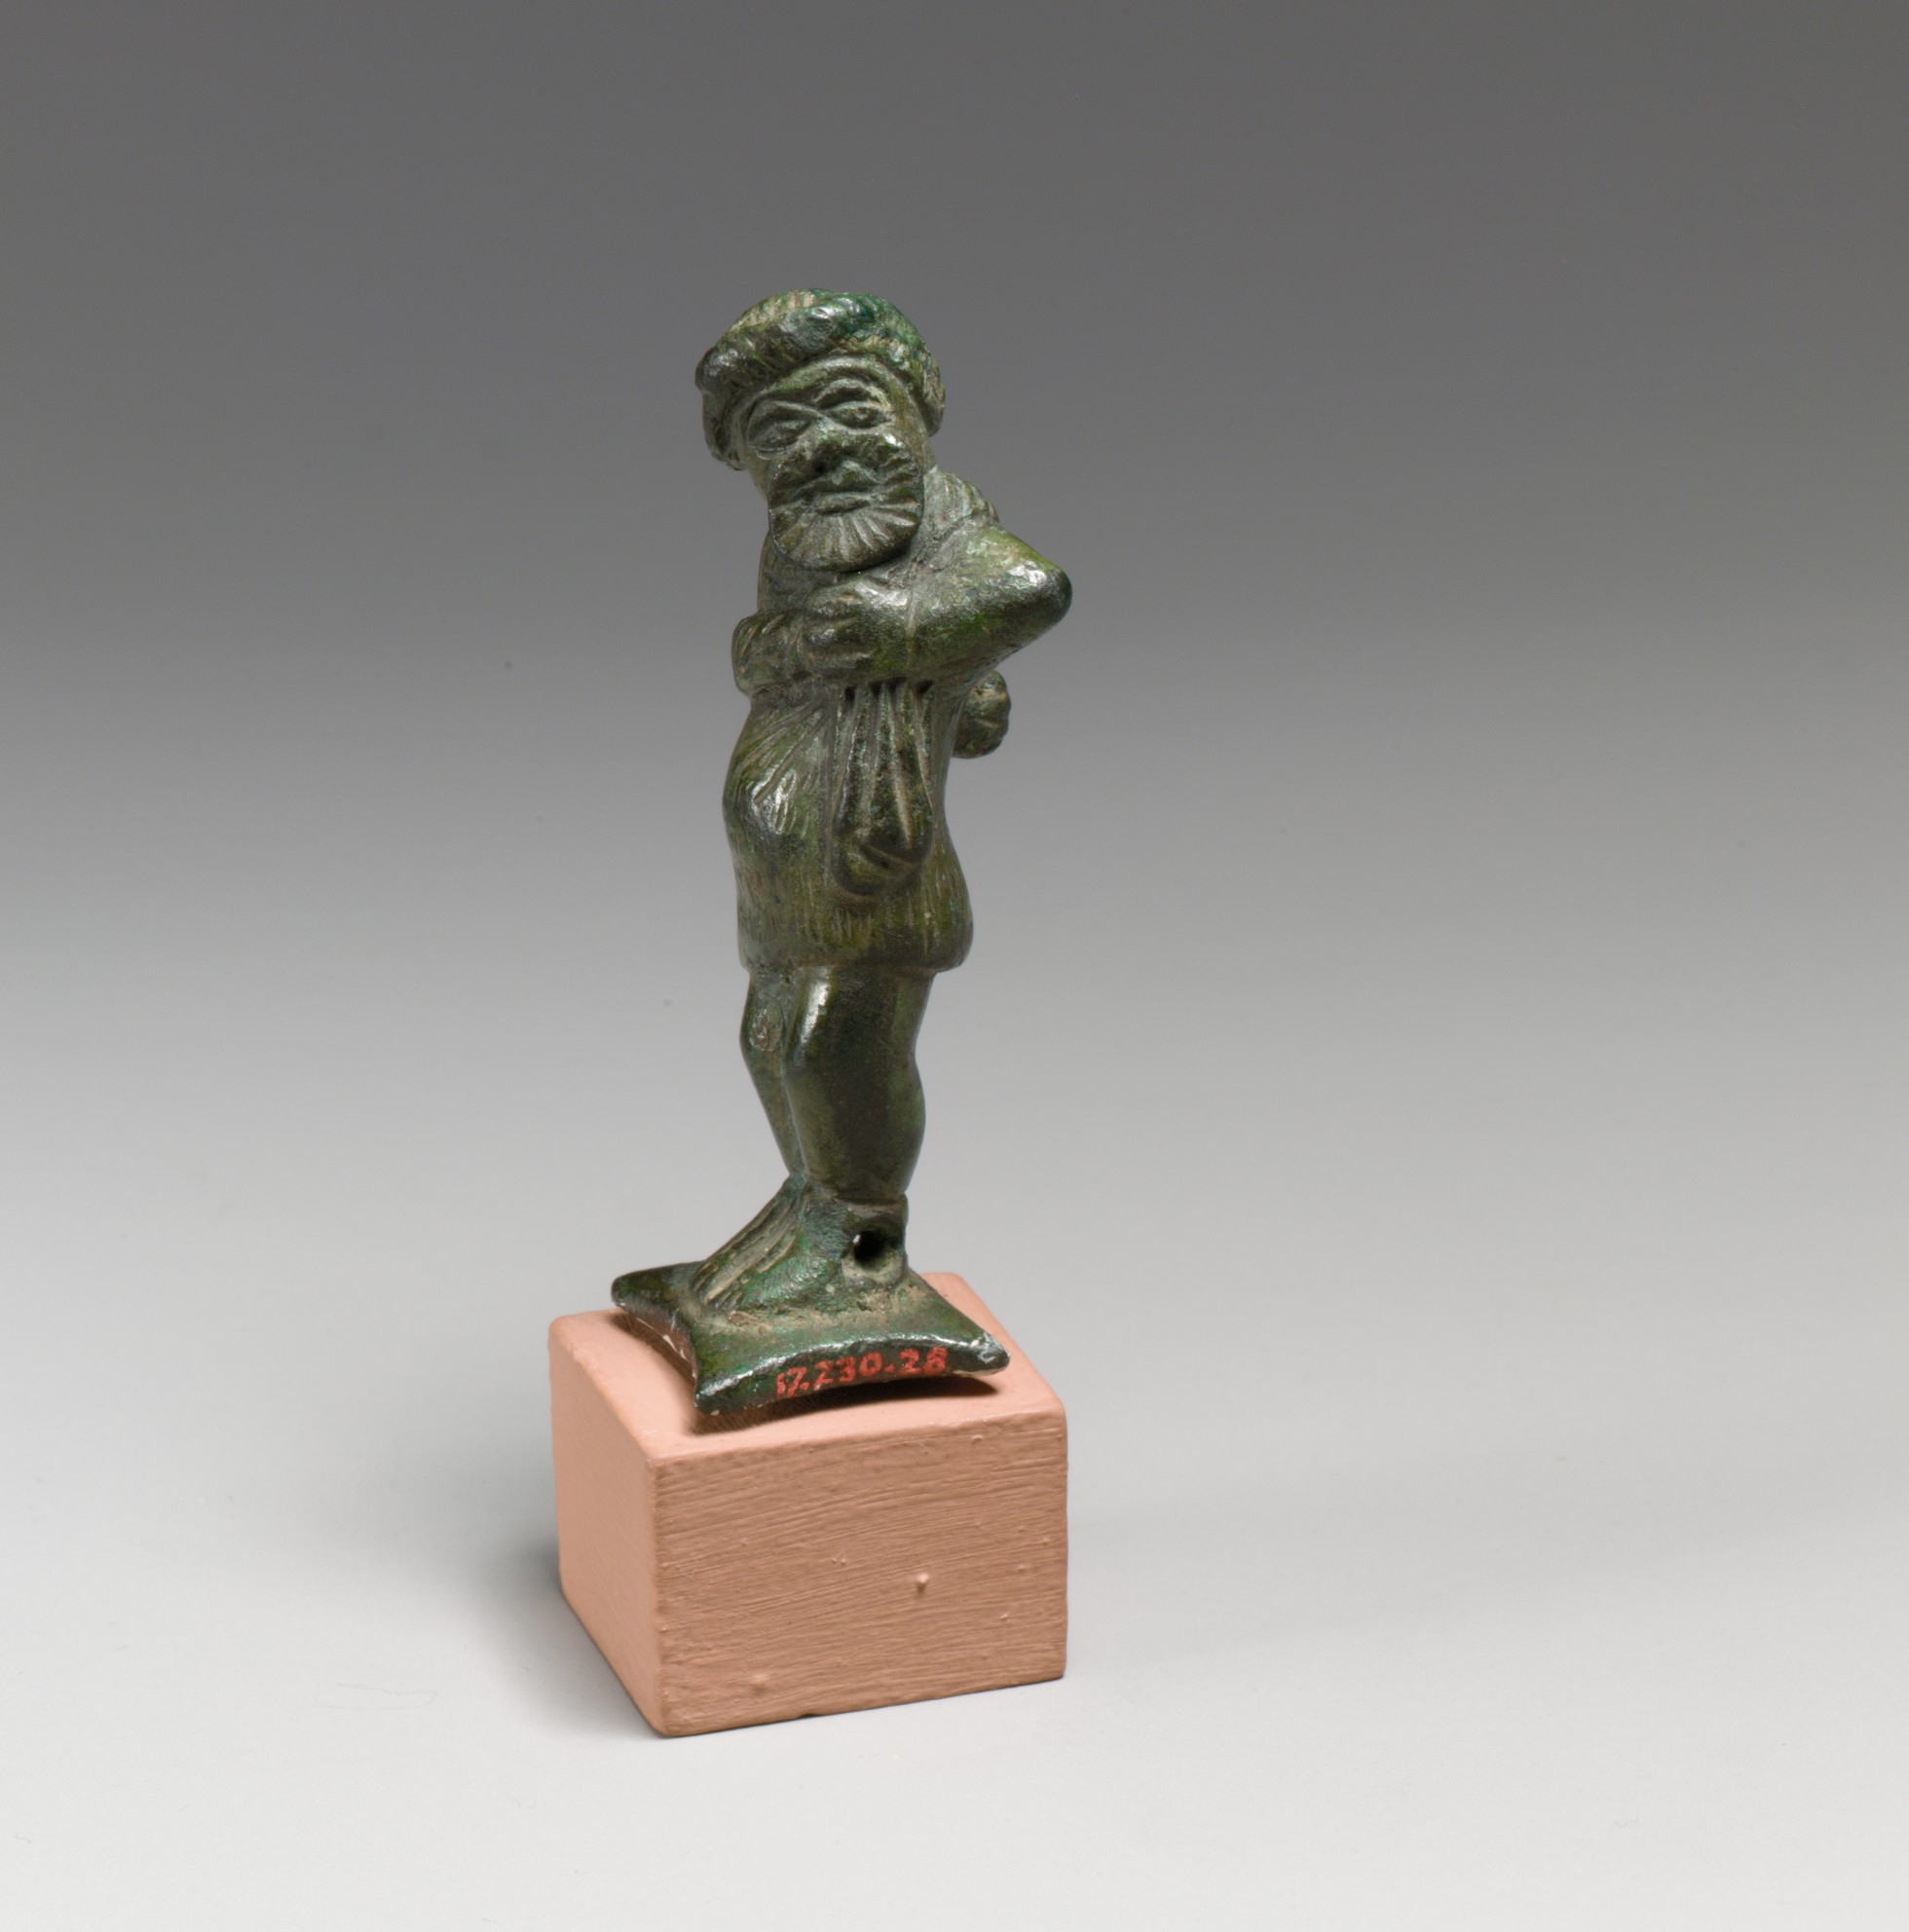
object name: statuette of an actor, comic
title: Bronze statuette of a comic actor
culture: roman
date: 1-200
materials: bronze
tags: men,actors